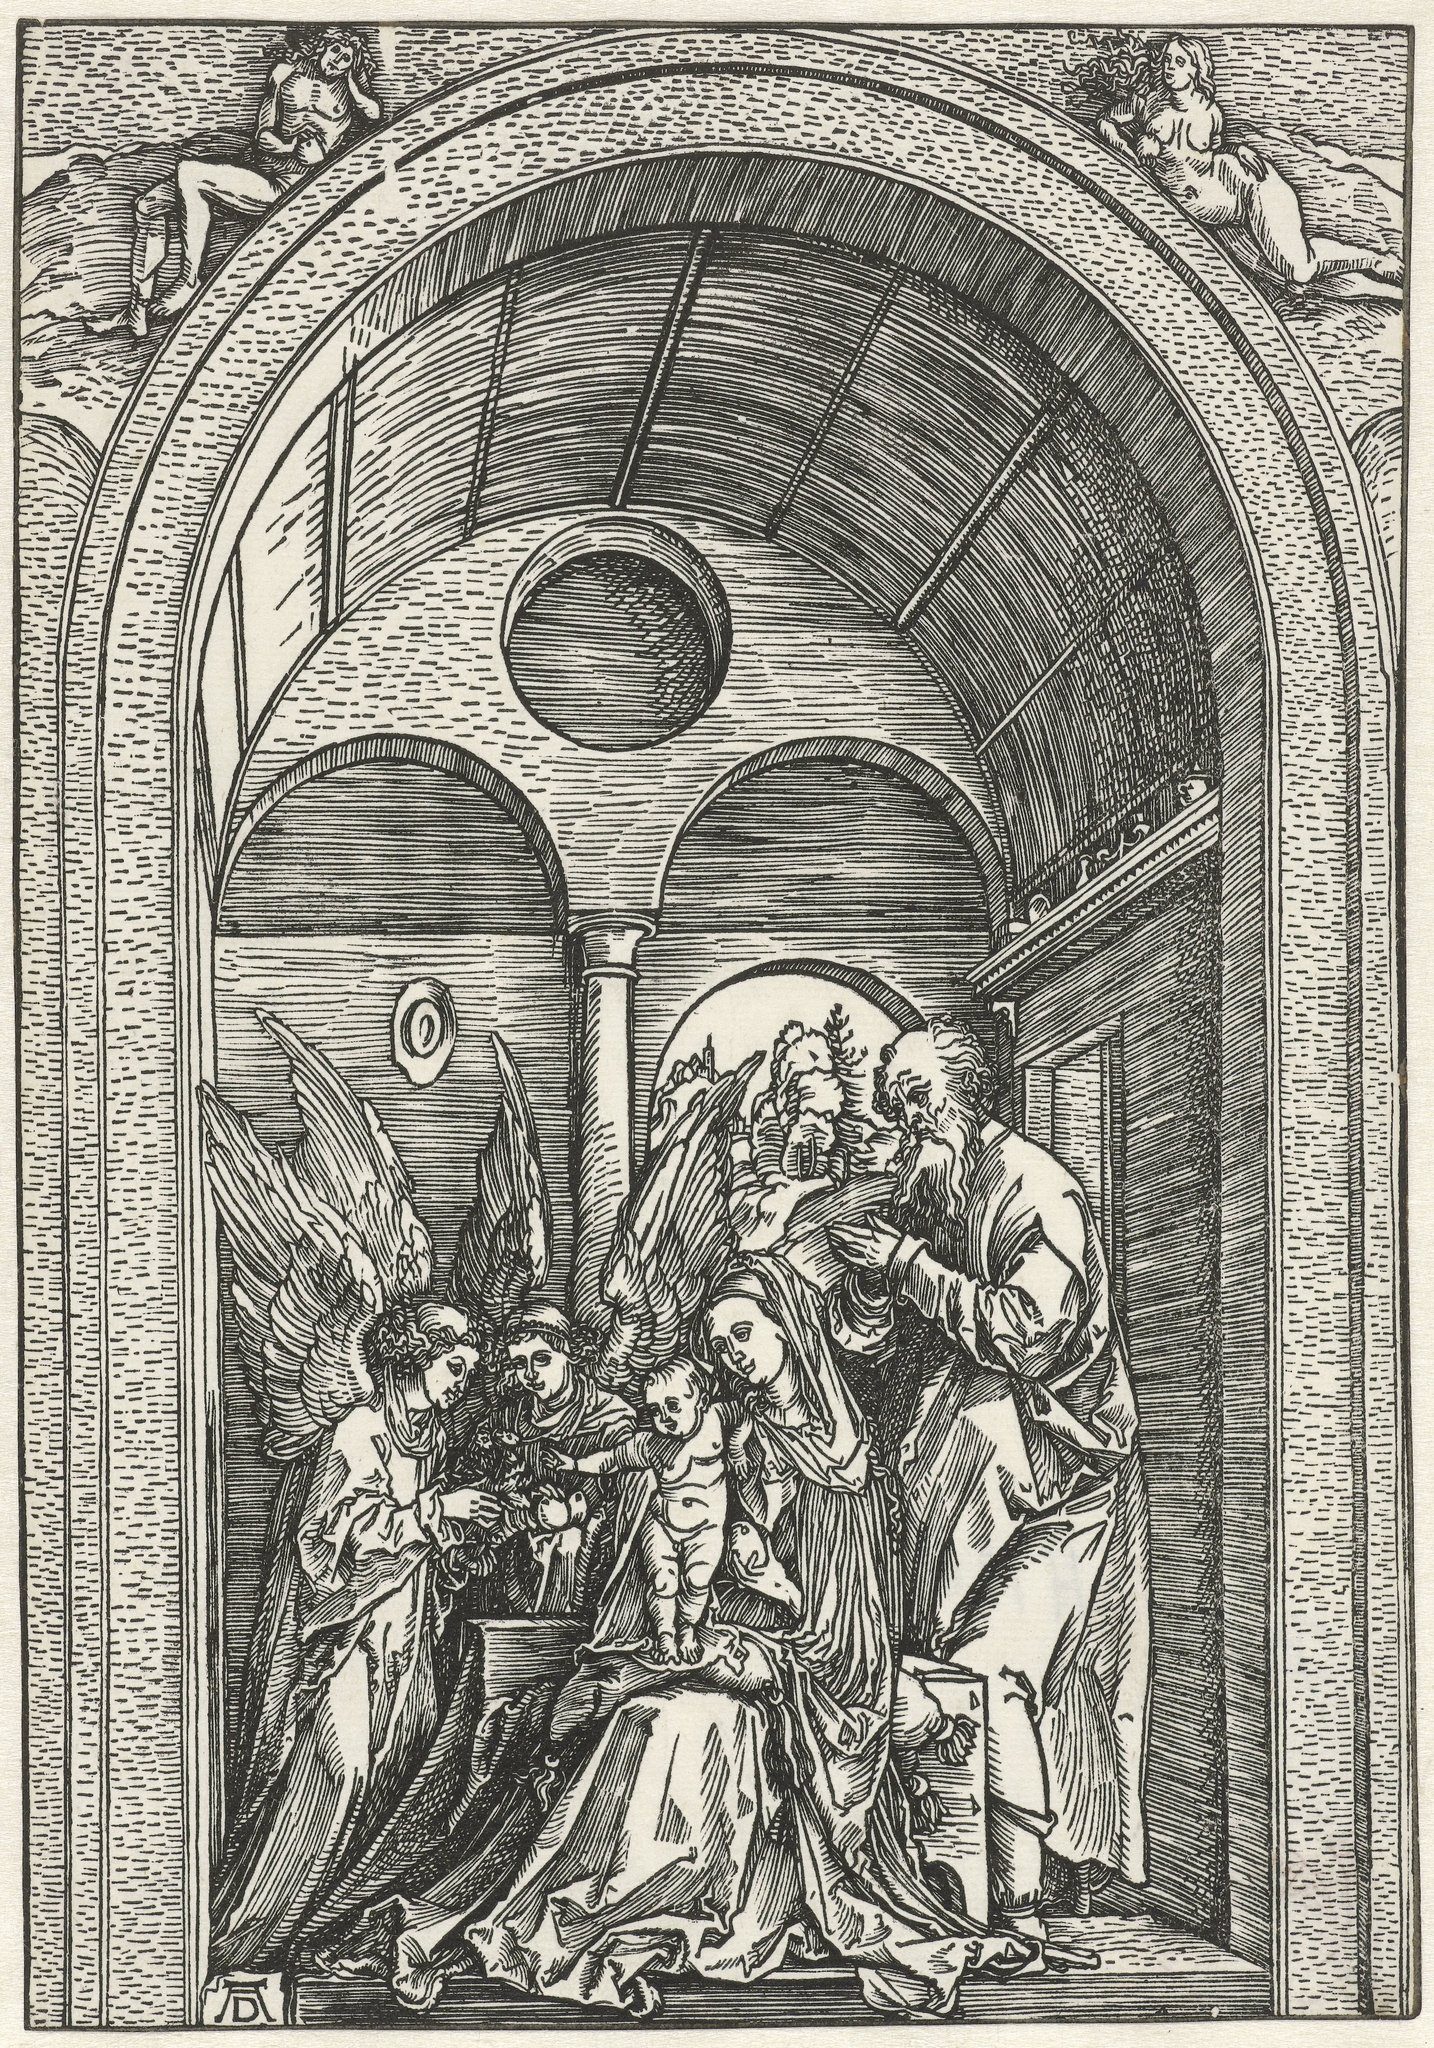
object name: print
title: De Heilige Familie met twee engelen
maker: albrecht dürer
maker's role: draughtsman, painter, print maker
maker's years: 1471-1528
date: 1503-1504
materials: paper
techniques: woodcut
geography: nuremberg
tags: holy family, and derived representations, mary sitting or enthroned, the christ-child in front of her, standing in her lap (or in front of her bosom), angels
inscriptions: collector's mark: Lugt 240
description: Maria zit op een bank in een gewelfde ruimte en houdt het Christuskind, dat op haar schoot staat, een appel of peer voor. Twee engelen aan haar rechterzijde houden hem nog twee vruchten voor. Jozef staat achter zijn vrouw en kind.